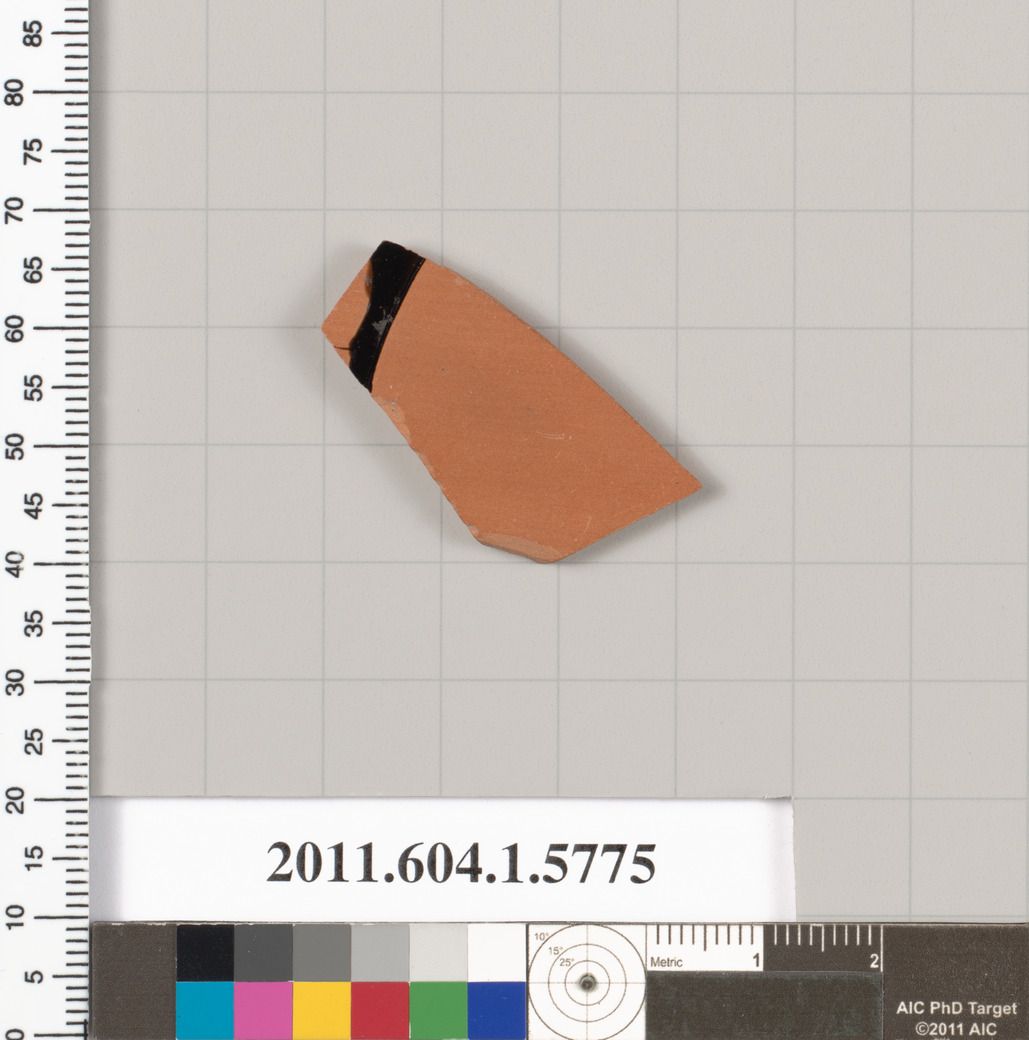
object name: kylix fragment, eye cup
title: Terracotta fragment of a kylix: eye-cup (drinking cup)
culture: greek, attic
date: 520-510 BCE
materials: terracotta